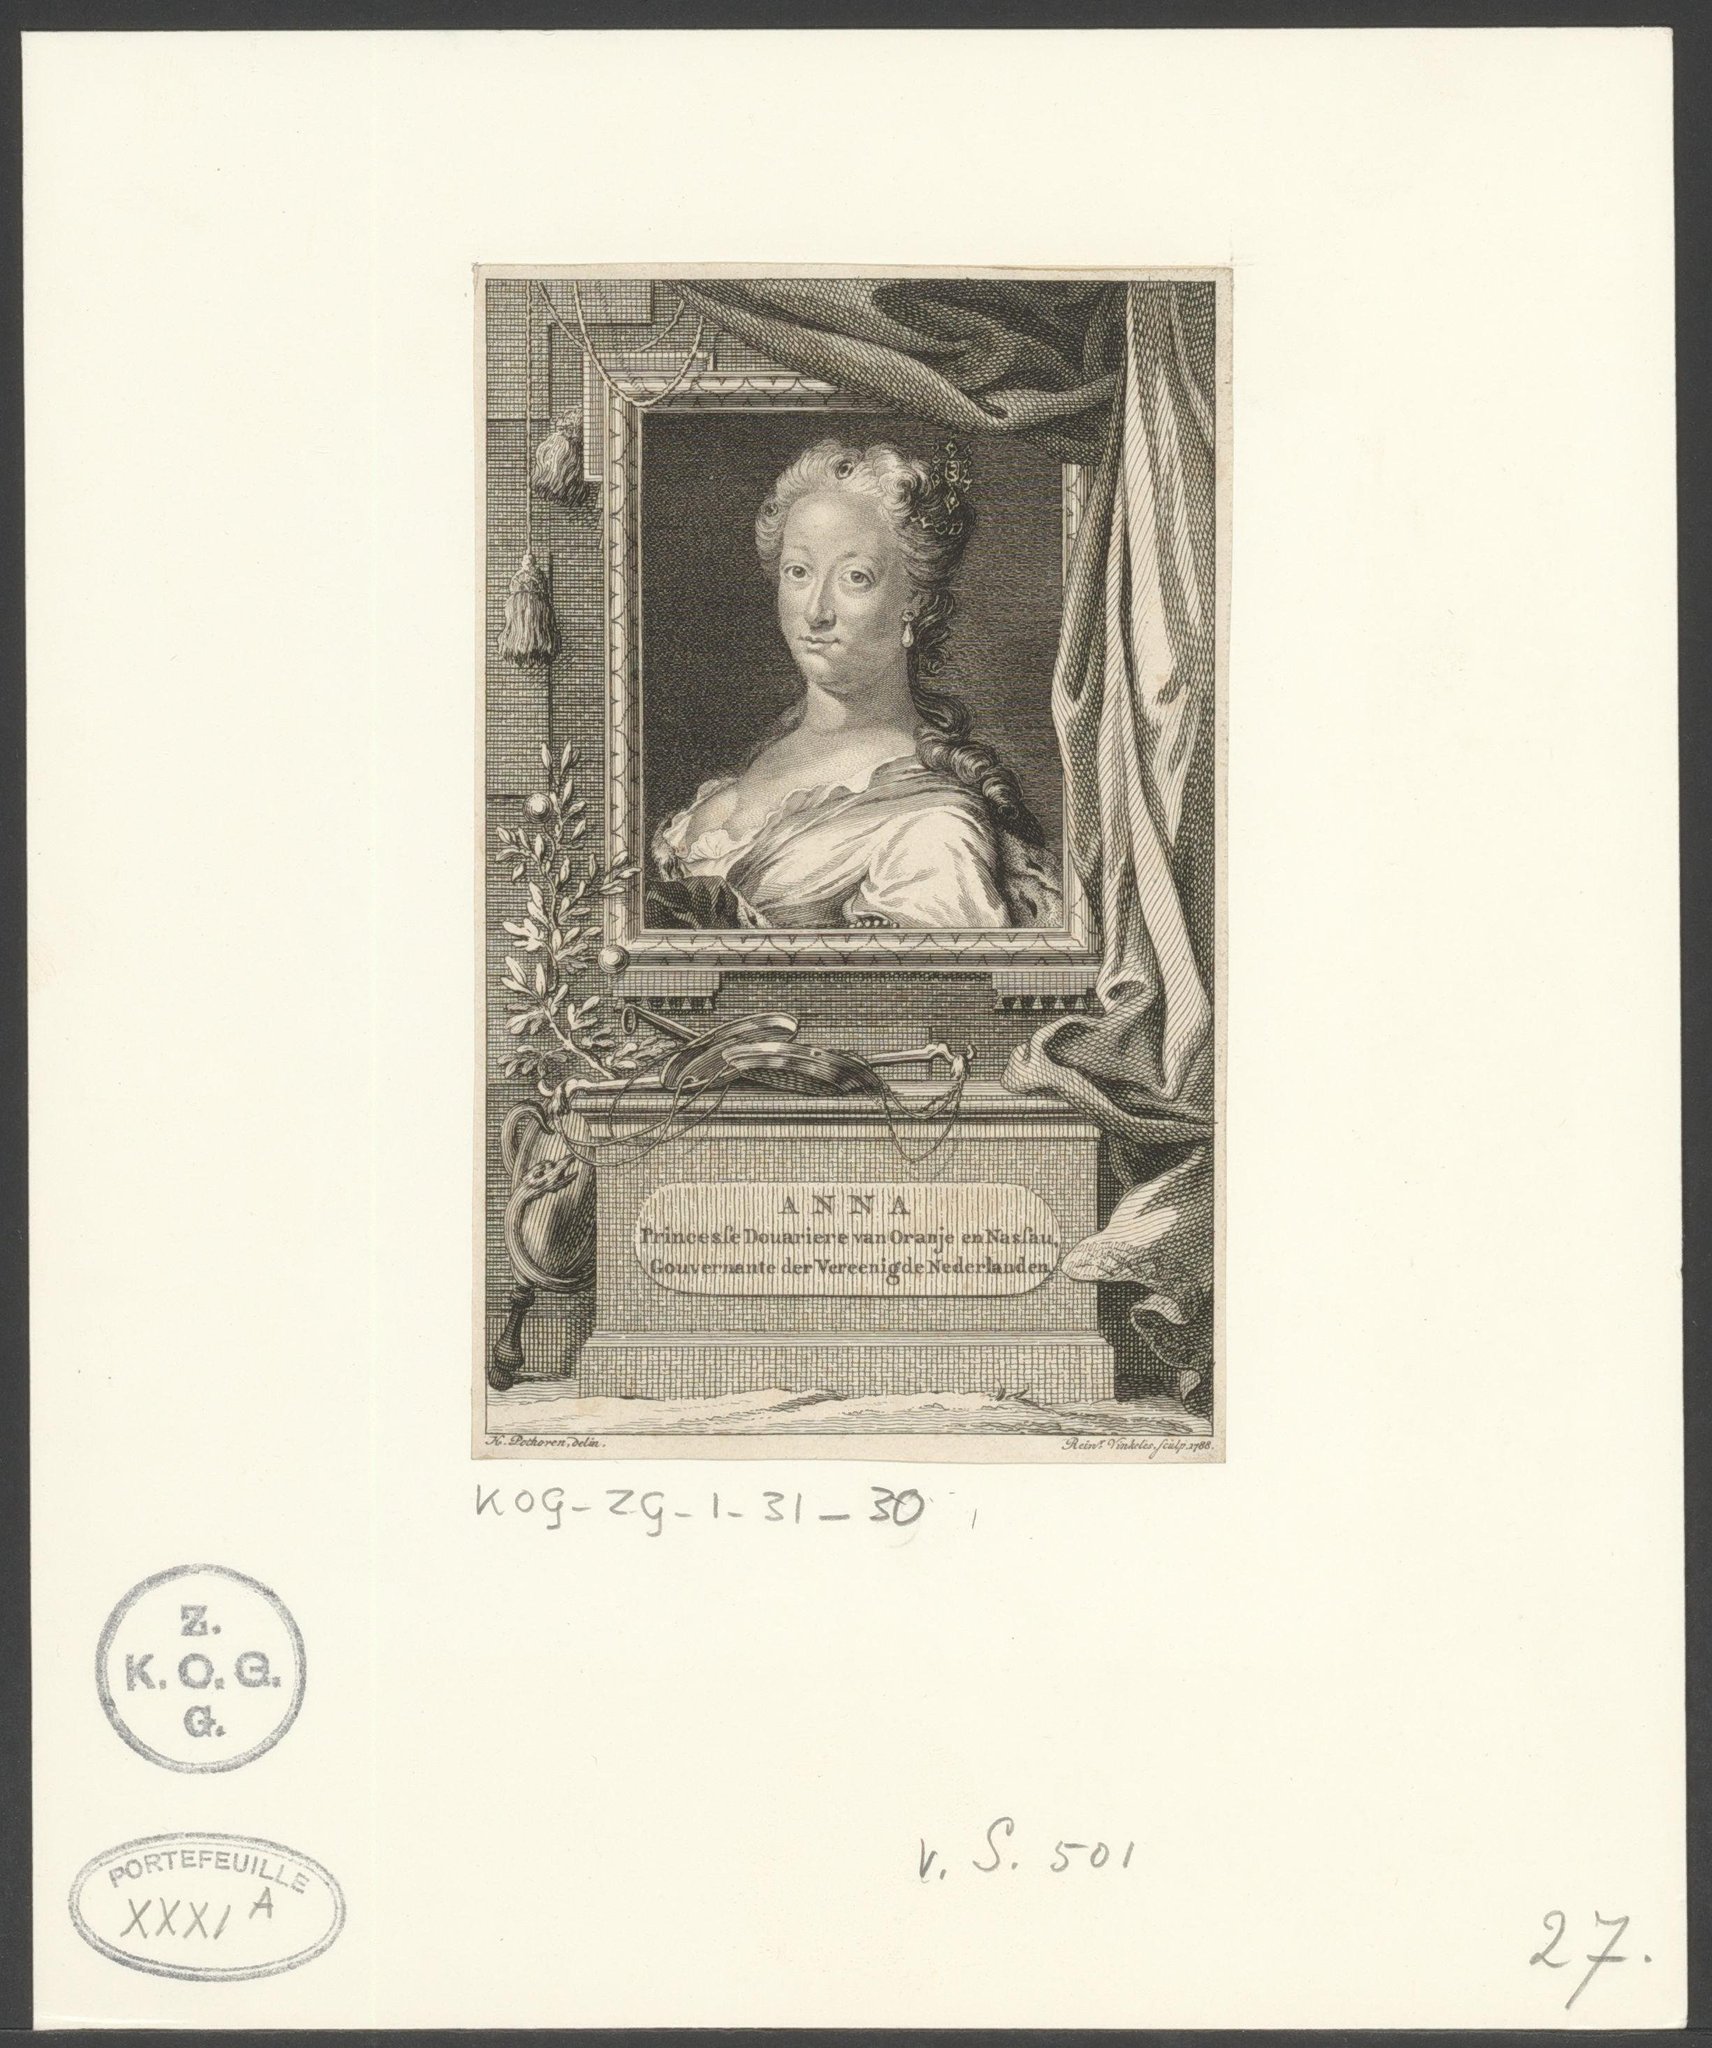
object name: print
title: Portret van Anna van Hannover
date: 1788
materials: paper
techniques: etching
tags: the hague, anna van hannover, historical persons - bb - woman, scales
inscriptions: collector's mark: Lugt 1641, stamp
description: Onderwerpsrubrieken binnen de Atlas Zeden en Gewoonten: Portretten, Portretten van Vorsten uit het huis van Oranje, Regeerende Vorsten, Stadhouders van Holland, Zeeland en West-Friesland.